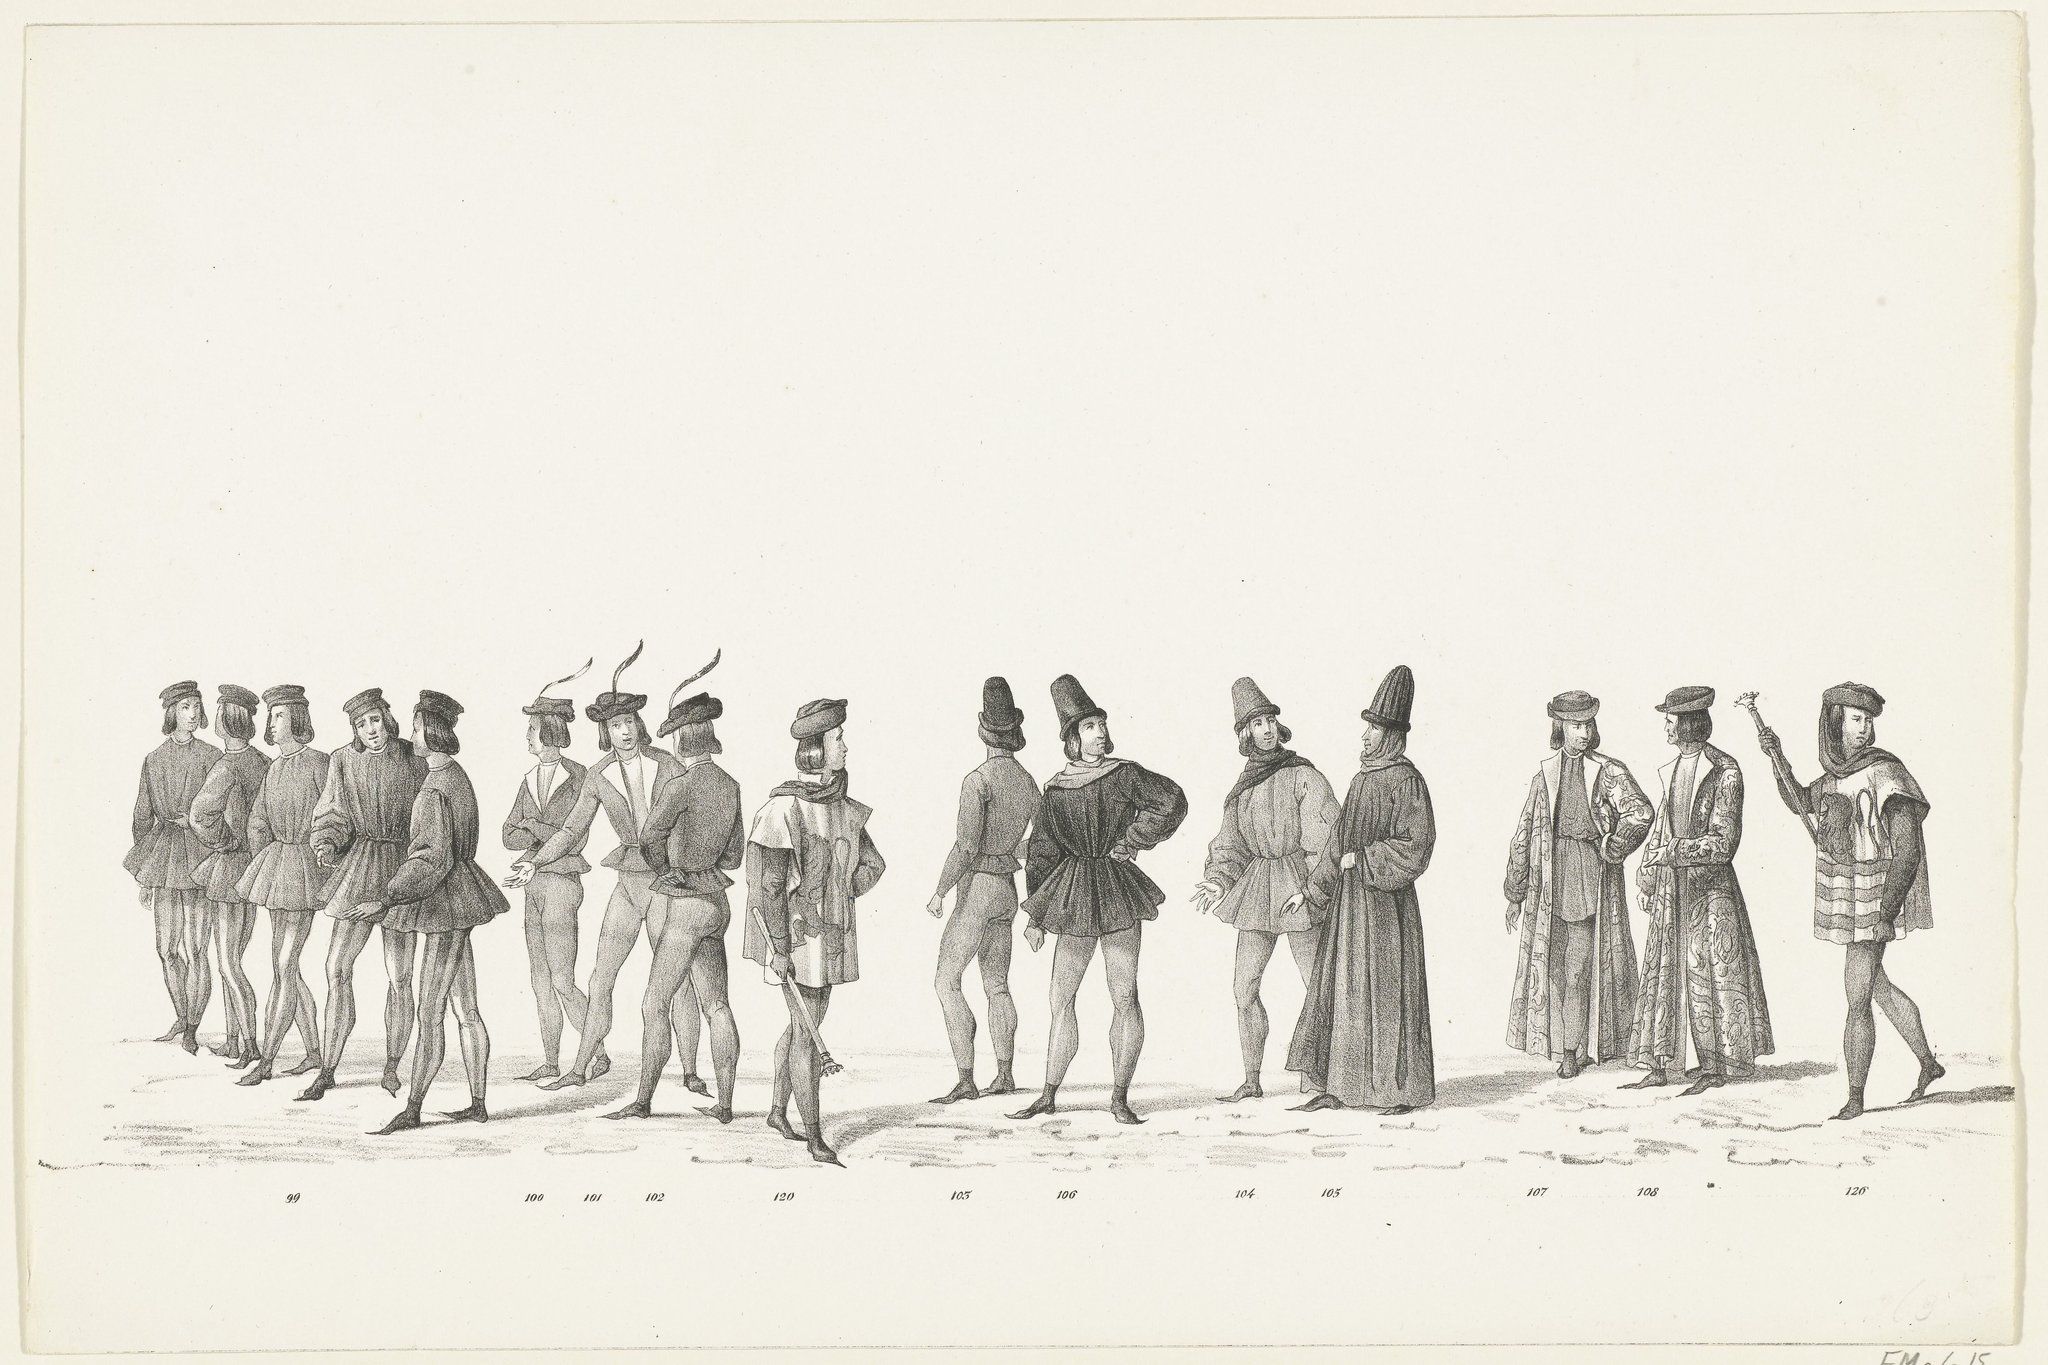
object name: print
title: Maskerade van de intocht van hertog Jan van Beieren te Leiden op 18 augustus 1420 door de Leidse studenten op 8 februari 1840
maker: Anonymous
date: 1840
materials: paper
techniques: lithograph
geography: netherlands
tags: jan van beieren, students' pageant, triumphal entry and public reception, pageant, 'entrée solennelle', 'joyeuse entrée', leiden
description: Optocht nrs 99-108: kamerlingen, legerchirurgijns en Kabeljauwgezinde Leidenaren. Onderdeel van de prentserie van de Maskerade van de intocht van hertog Jan van Beieren te Leiden op 18 augustus 1420 door de Leidse studenten op 8 februari 1840.